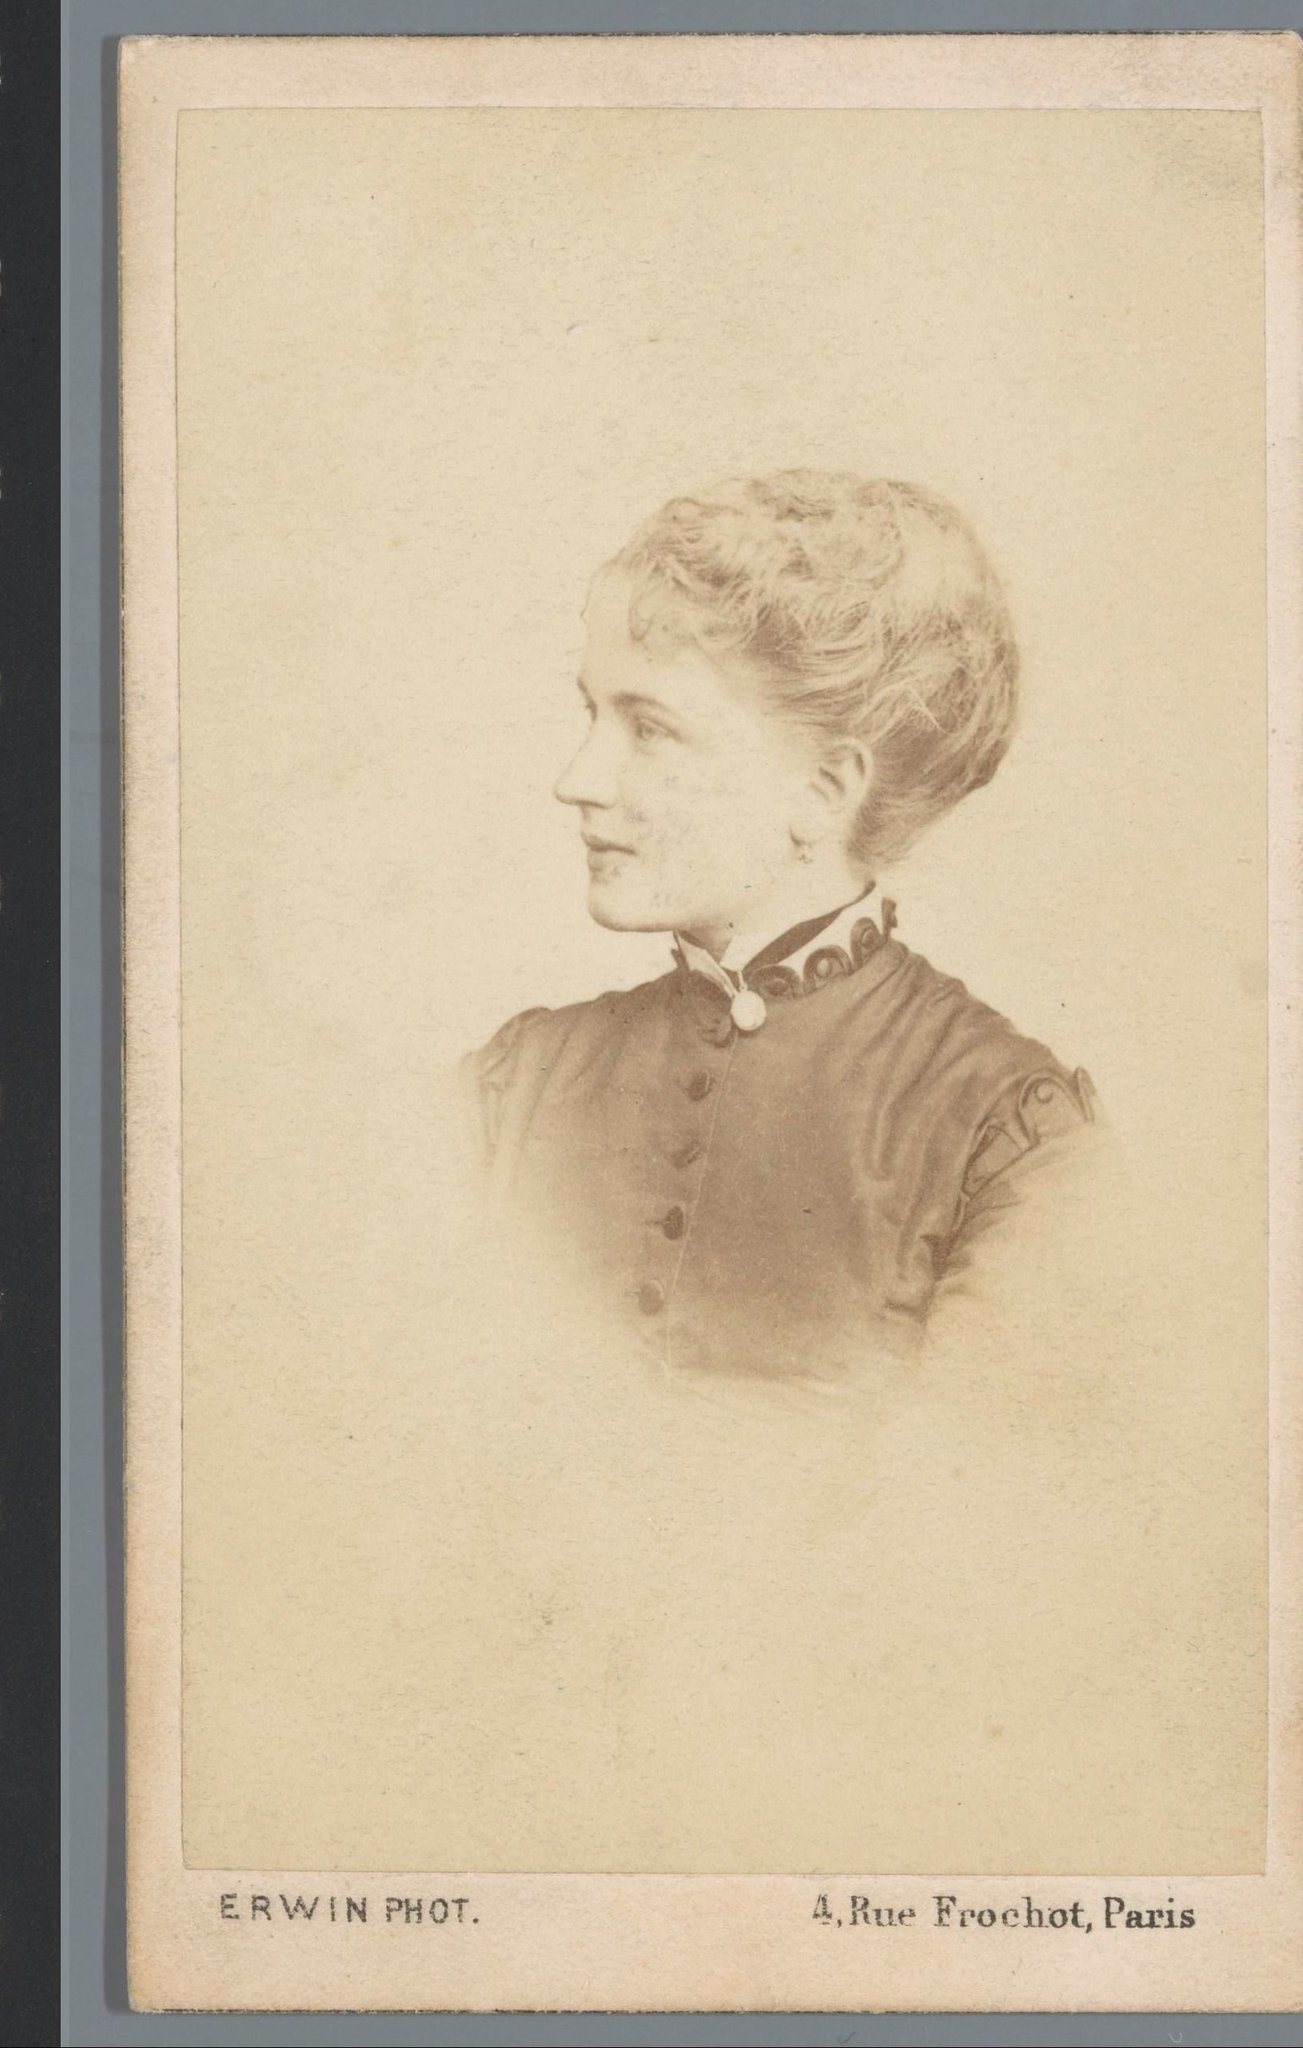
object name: carte de visite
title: Portret van een onbekende vrouw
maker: erwin hanfstaengl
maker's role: fotograaf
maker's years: 1837-1905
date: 1855-1885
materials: cardboard, paper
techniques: albumen print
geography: paris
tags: historical persons - bb - woman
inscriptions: inscription: ‘à Madame/ Membieé/’, inscription: ‘ERWIN/ HANFSTAENGL/ 4, Rue Frochot/ PARIS./ (Quartier St. Georges)’